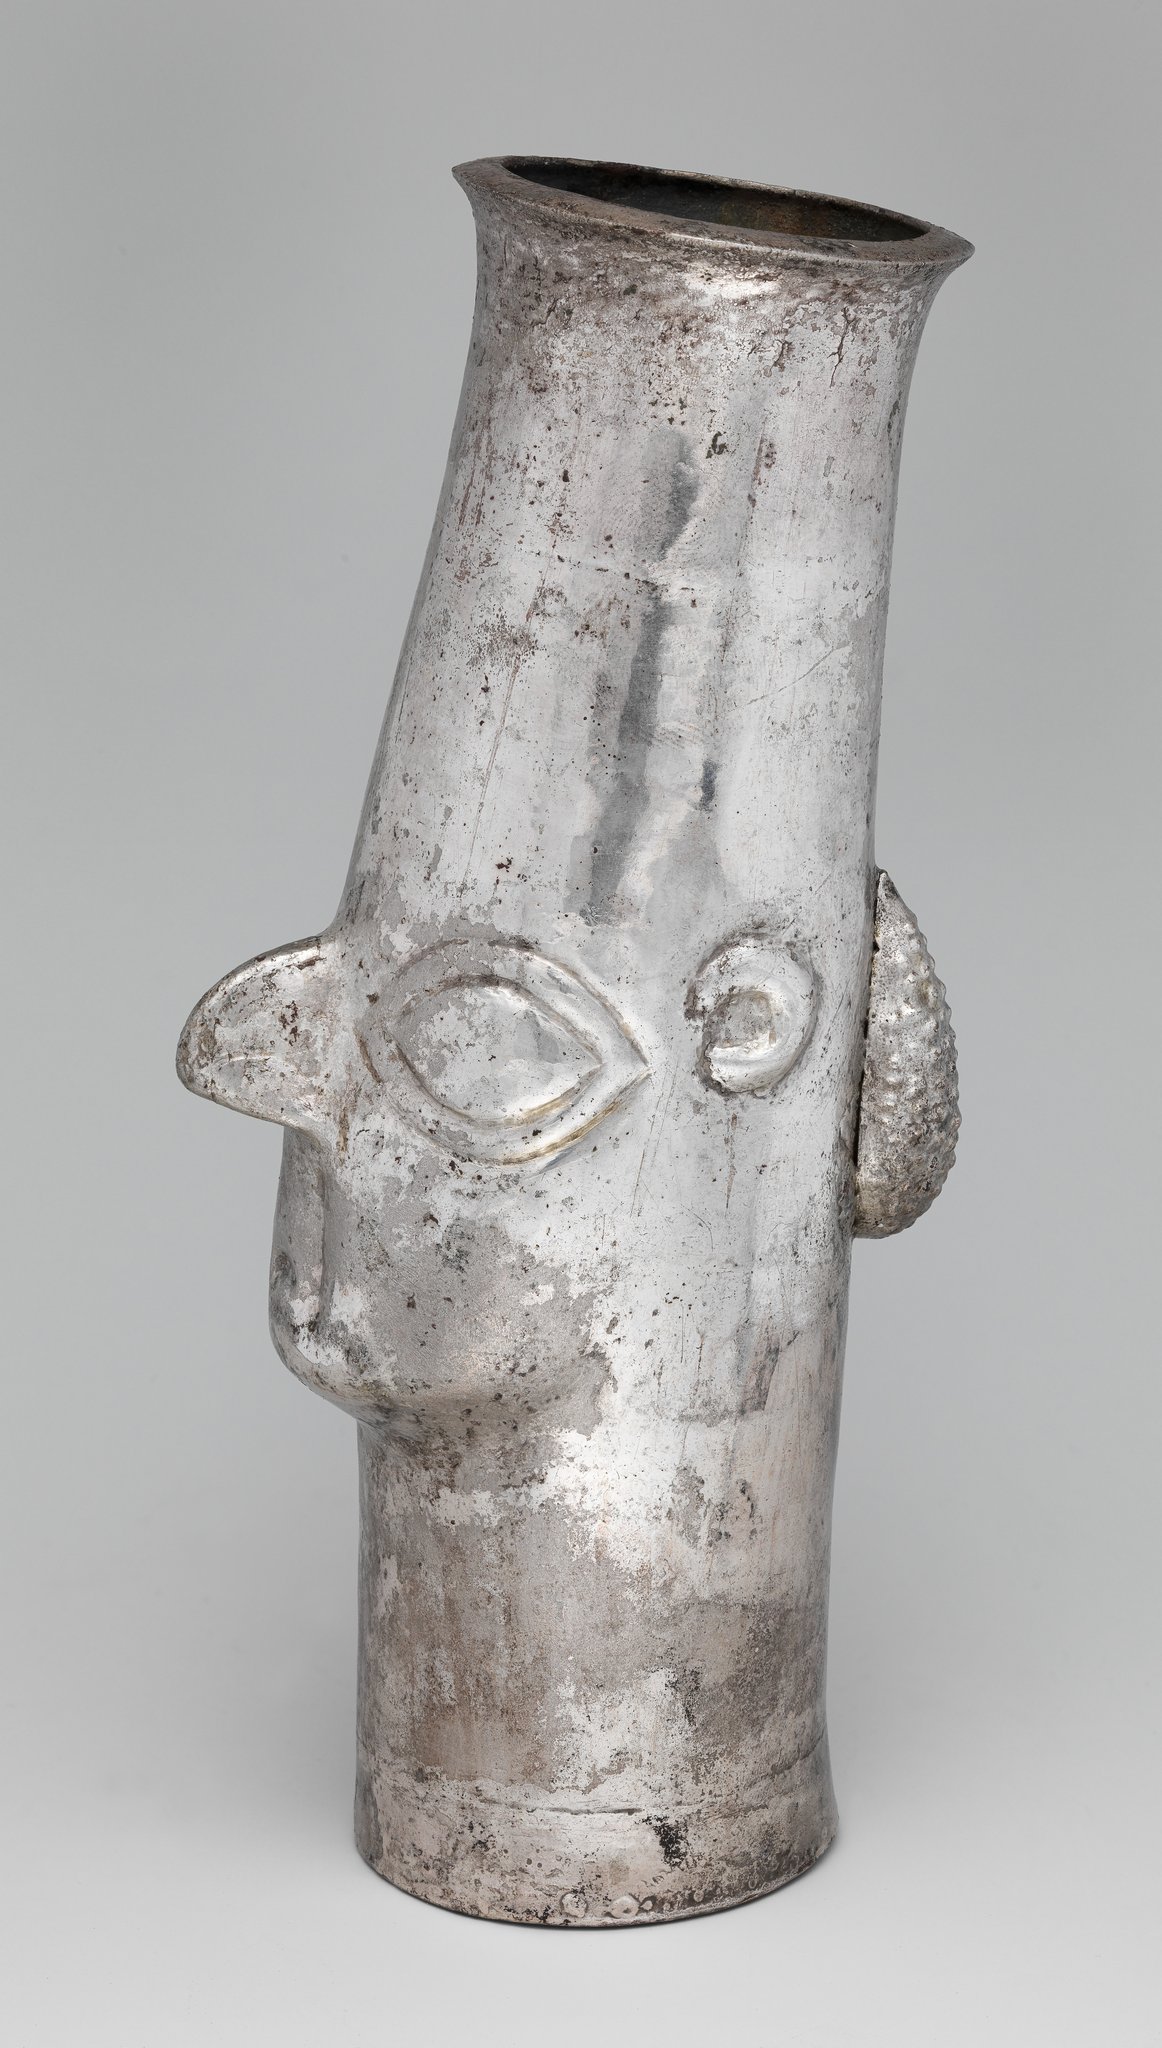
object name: beaker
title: Beaker with face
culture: inca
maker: inca artist(s)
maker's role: artist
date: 1400-1535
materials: silver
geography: peru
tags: faces